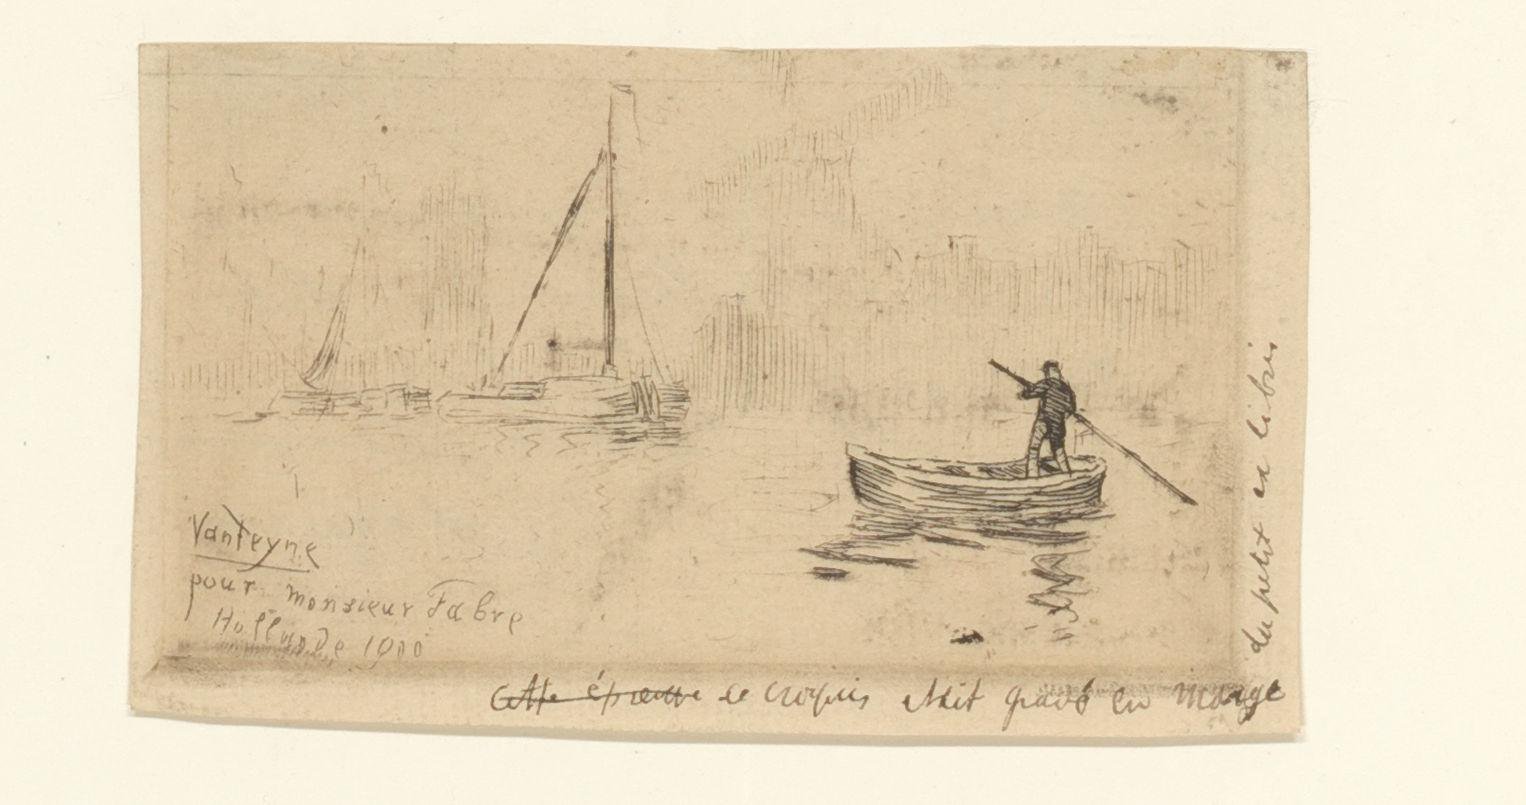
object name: bookplate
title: Ex libris van Eugène Fabre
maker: anthonie van teijn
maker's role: draughtsman, painter, print maker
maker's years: 1863-1943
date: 1900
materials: paper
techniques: etching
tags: ex-libris, rowing-boat, canoe, etc.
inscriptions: stamp, collector's mark: Lugt 1641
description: Onderwerpsrubrieken binnen de Atlas Zeden en Gewoonten: Schoone kunsten, Ex-libris en gelegenheidsgrafiek.